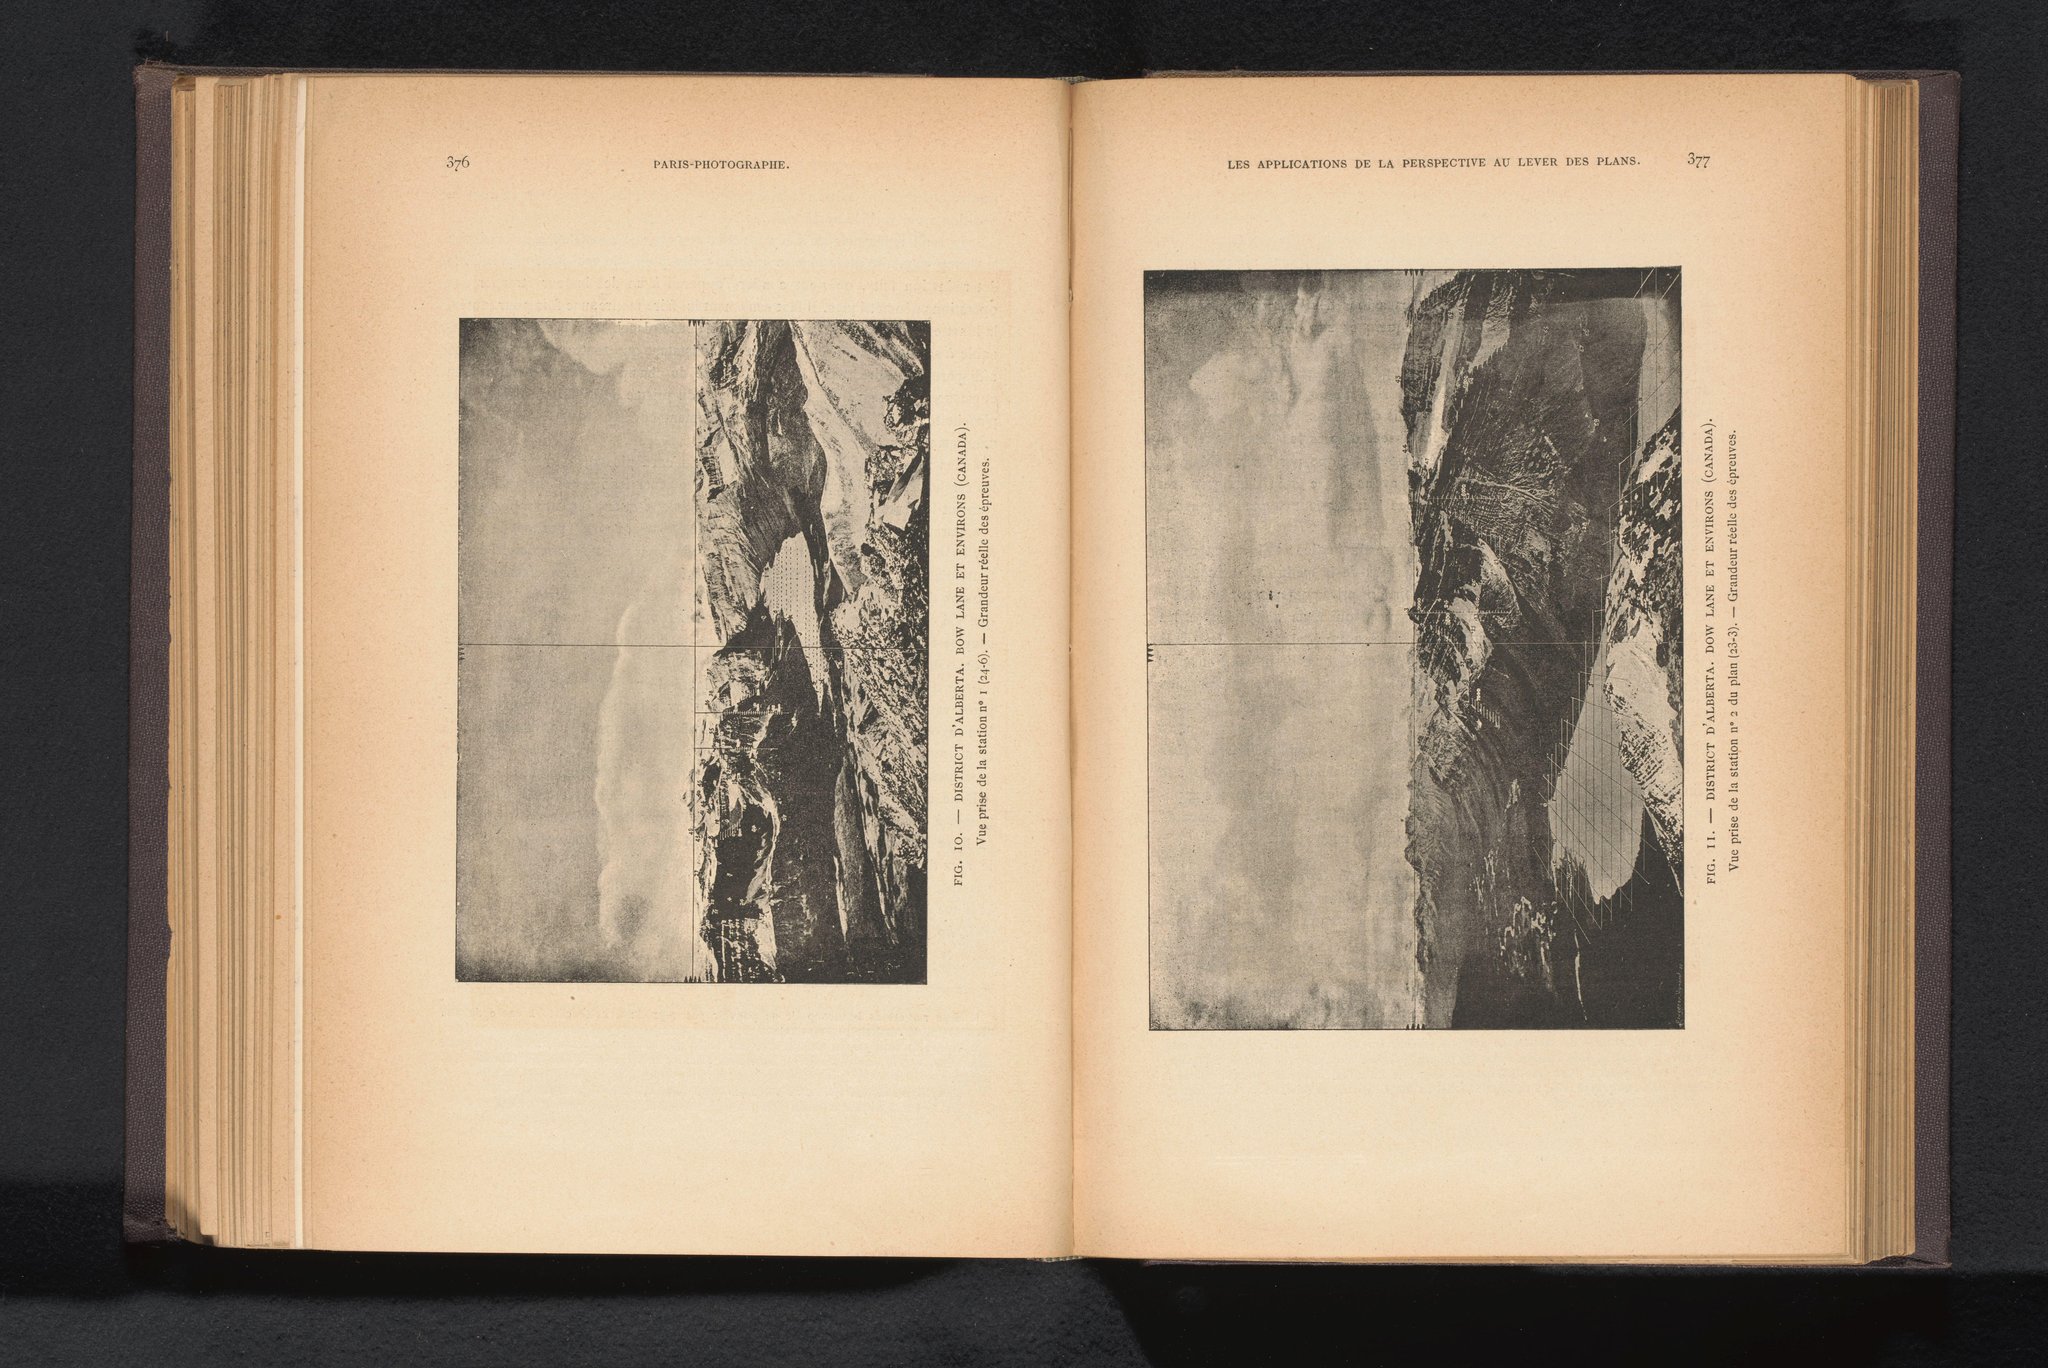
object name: photomechanical print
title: District d'Alberta. Bow Lane et environs (Canada)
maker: Anonymous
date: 1883-1893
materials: paper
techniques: autotype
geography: alberta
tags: landscapes in the temperate zone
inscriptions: inscription: ‘Vue prise de la station no. 1 (24-6).- Grandeur réelle des épreuves.’, number: ‘Fig. 10.’